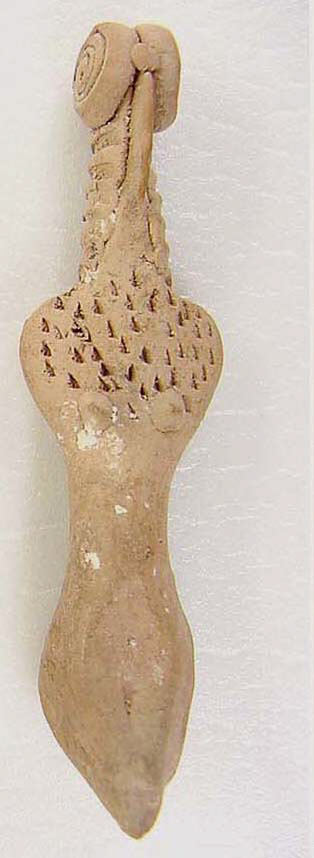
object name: figure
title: Goddess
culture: pakistani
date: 3500-3000 BCE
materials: terracotta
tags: indus valley,goddess